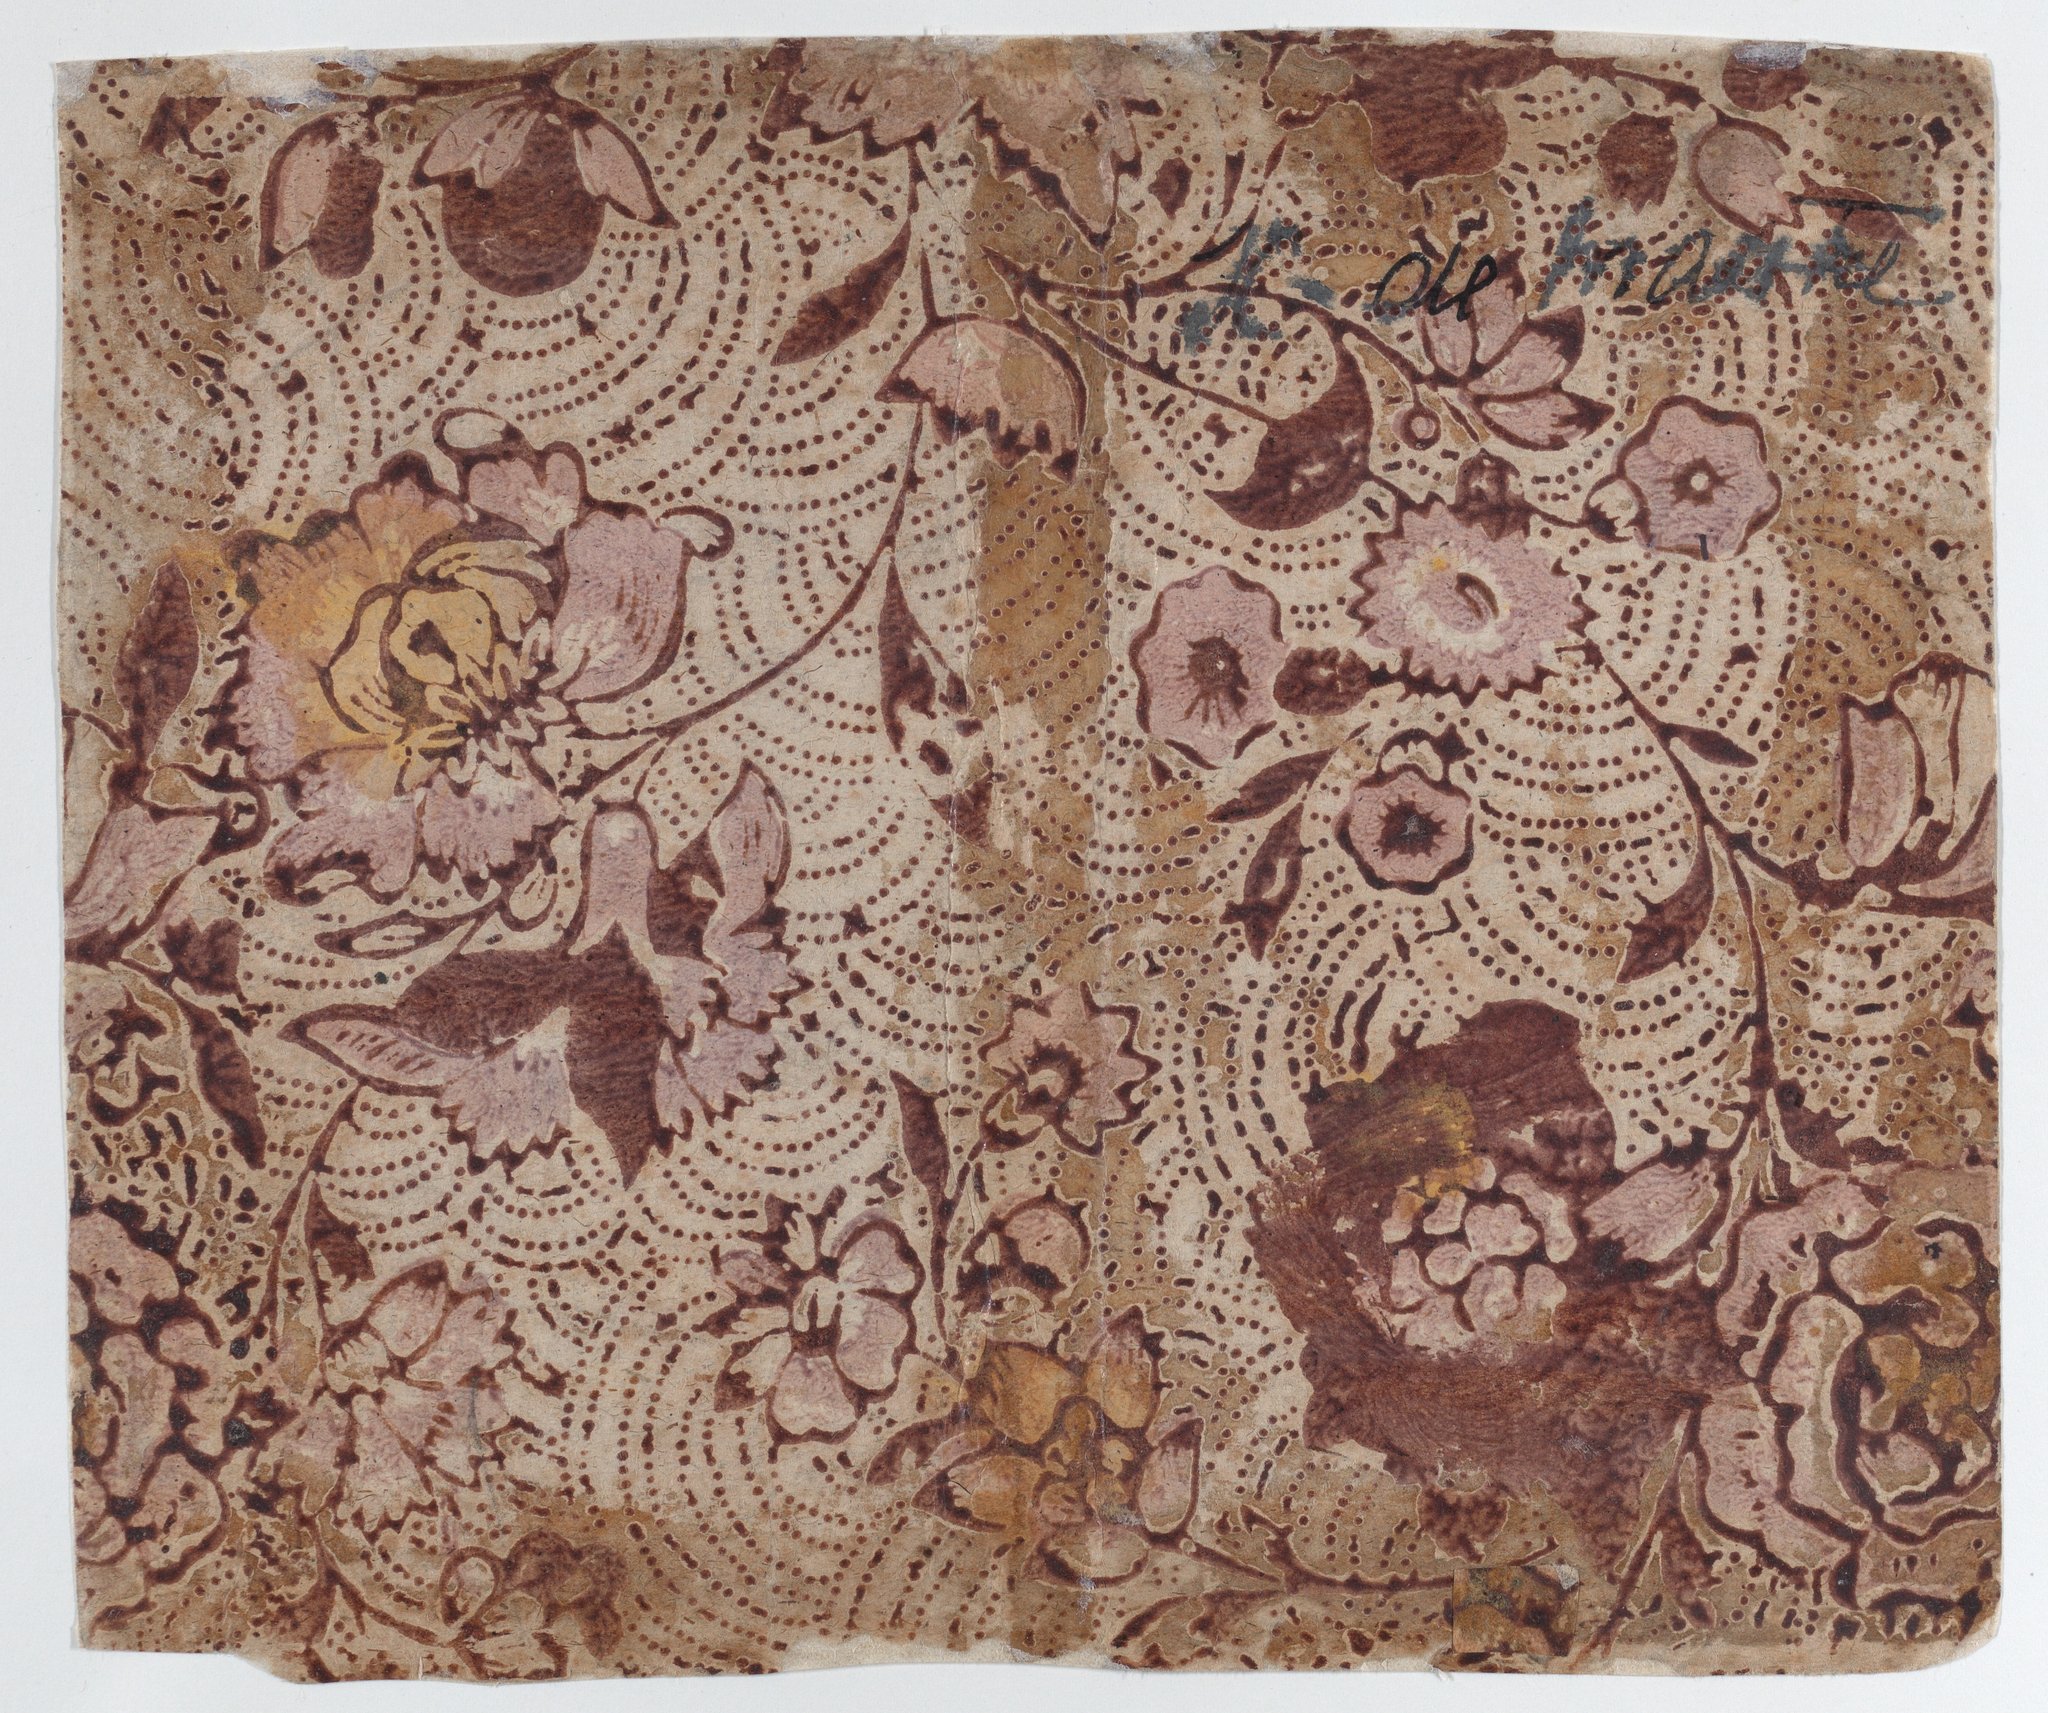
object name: print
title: Book cover with overall floral and dot pattern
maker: Anonymous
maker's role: artist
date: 1801-1900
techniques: relief print